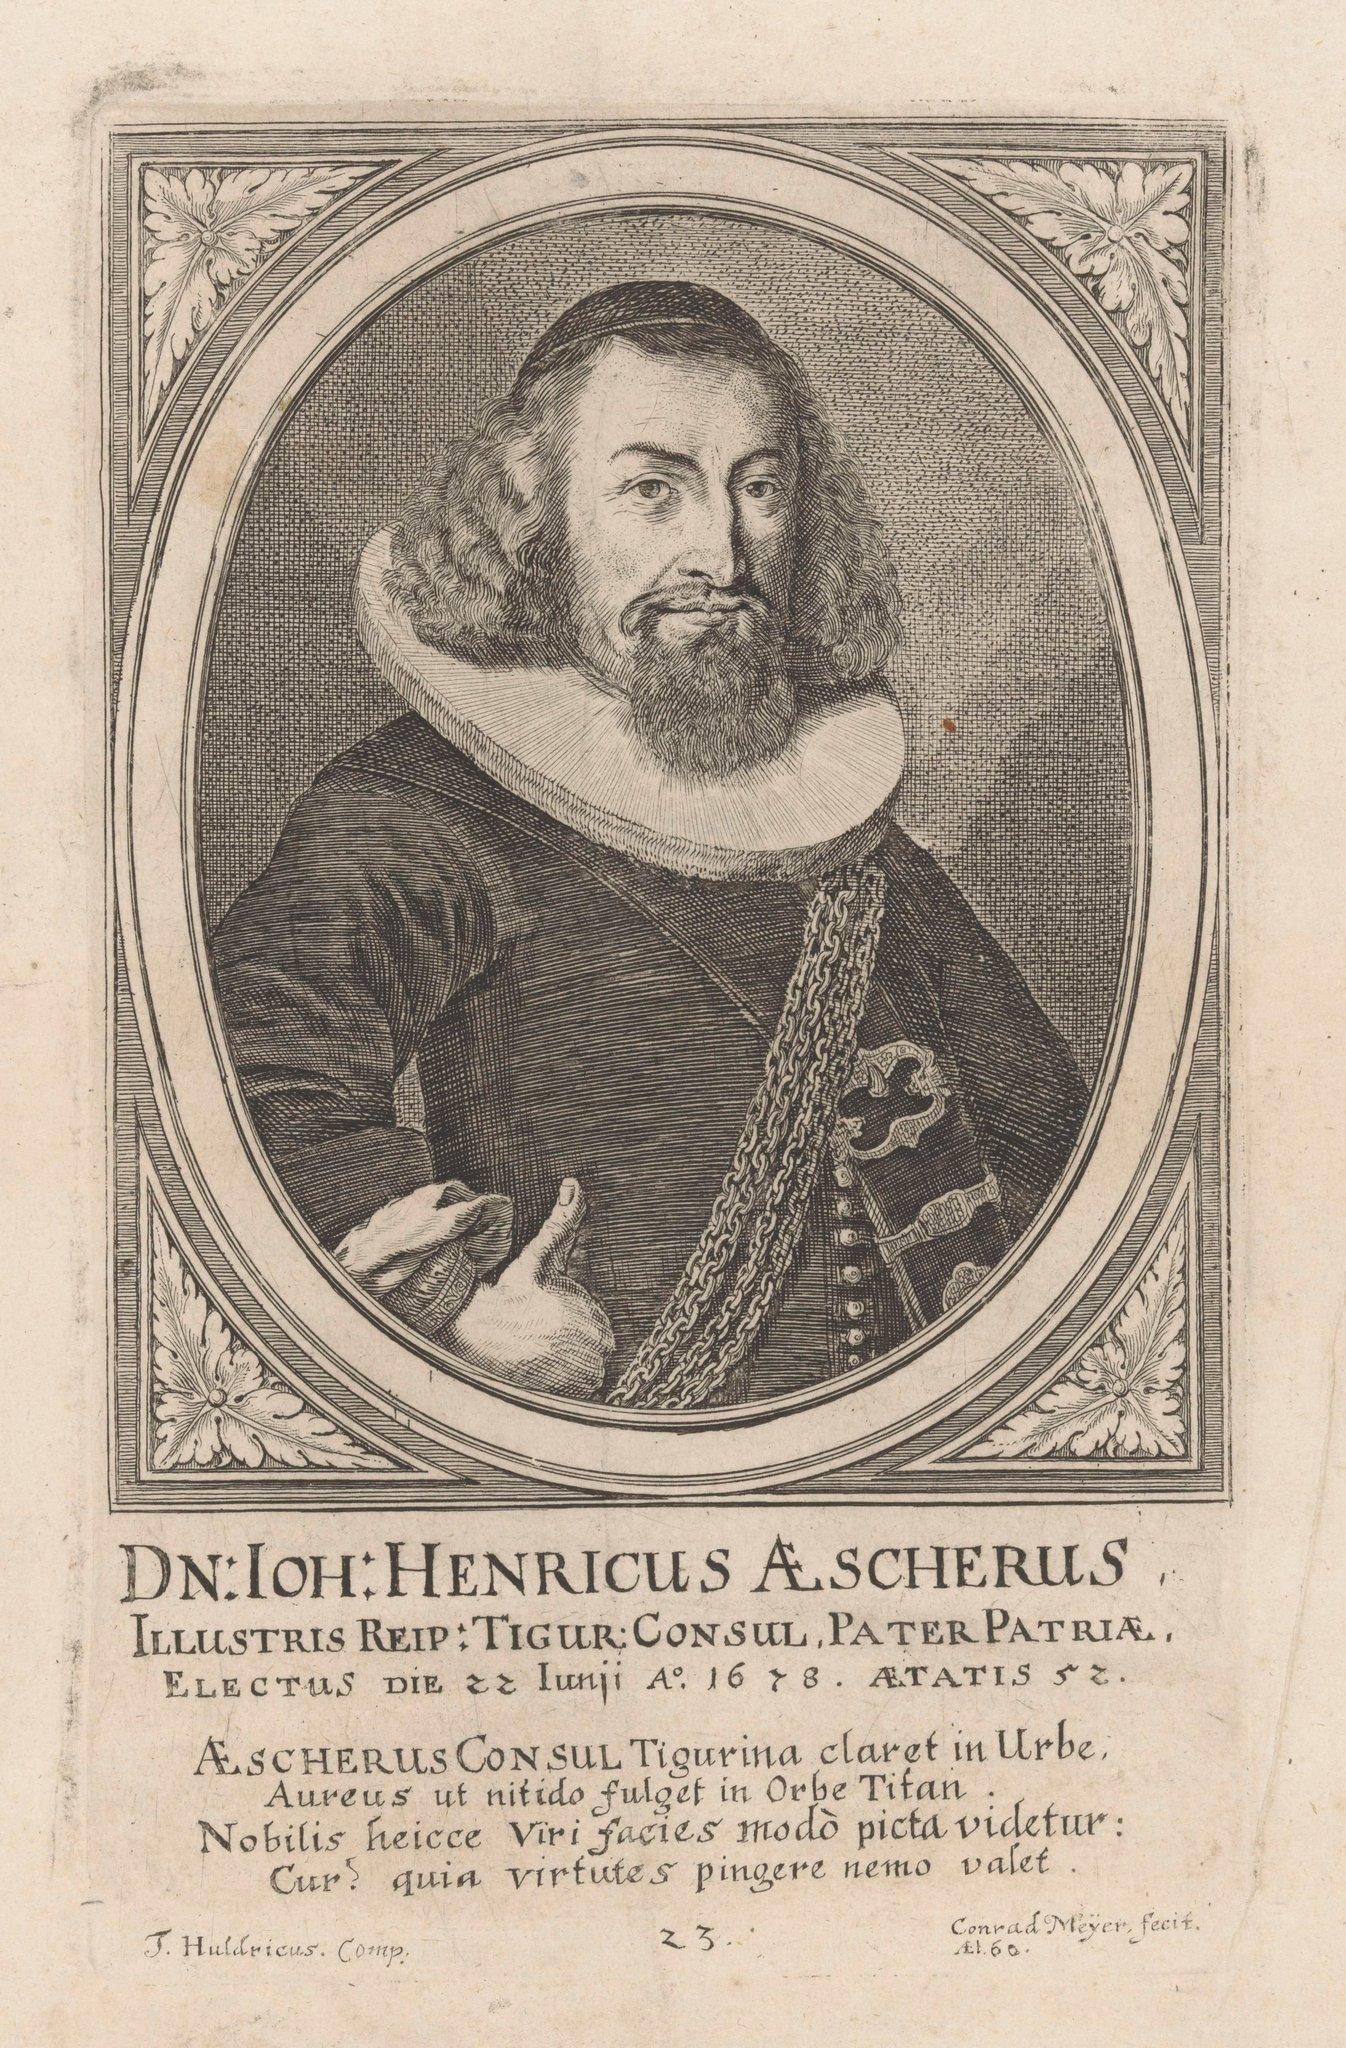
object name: print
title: Portret van Johann Heinrich Aescher op 52-jarige leeftijd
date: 1678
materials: paper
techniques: engraving, etching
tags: mayor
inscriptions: collector's mark: Lugt 2228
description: Portret van Johann Heinrich Aescher in een geornamenteerde, ovale omlijsting. In de ondermarge zijn naam, zijn titel, de datum van zijn electie, zijn leeftijd en vier regels Latijnse tekst. Midden onder: 23.